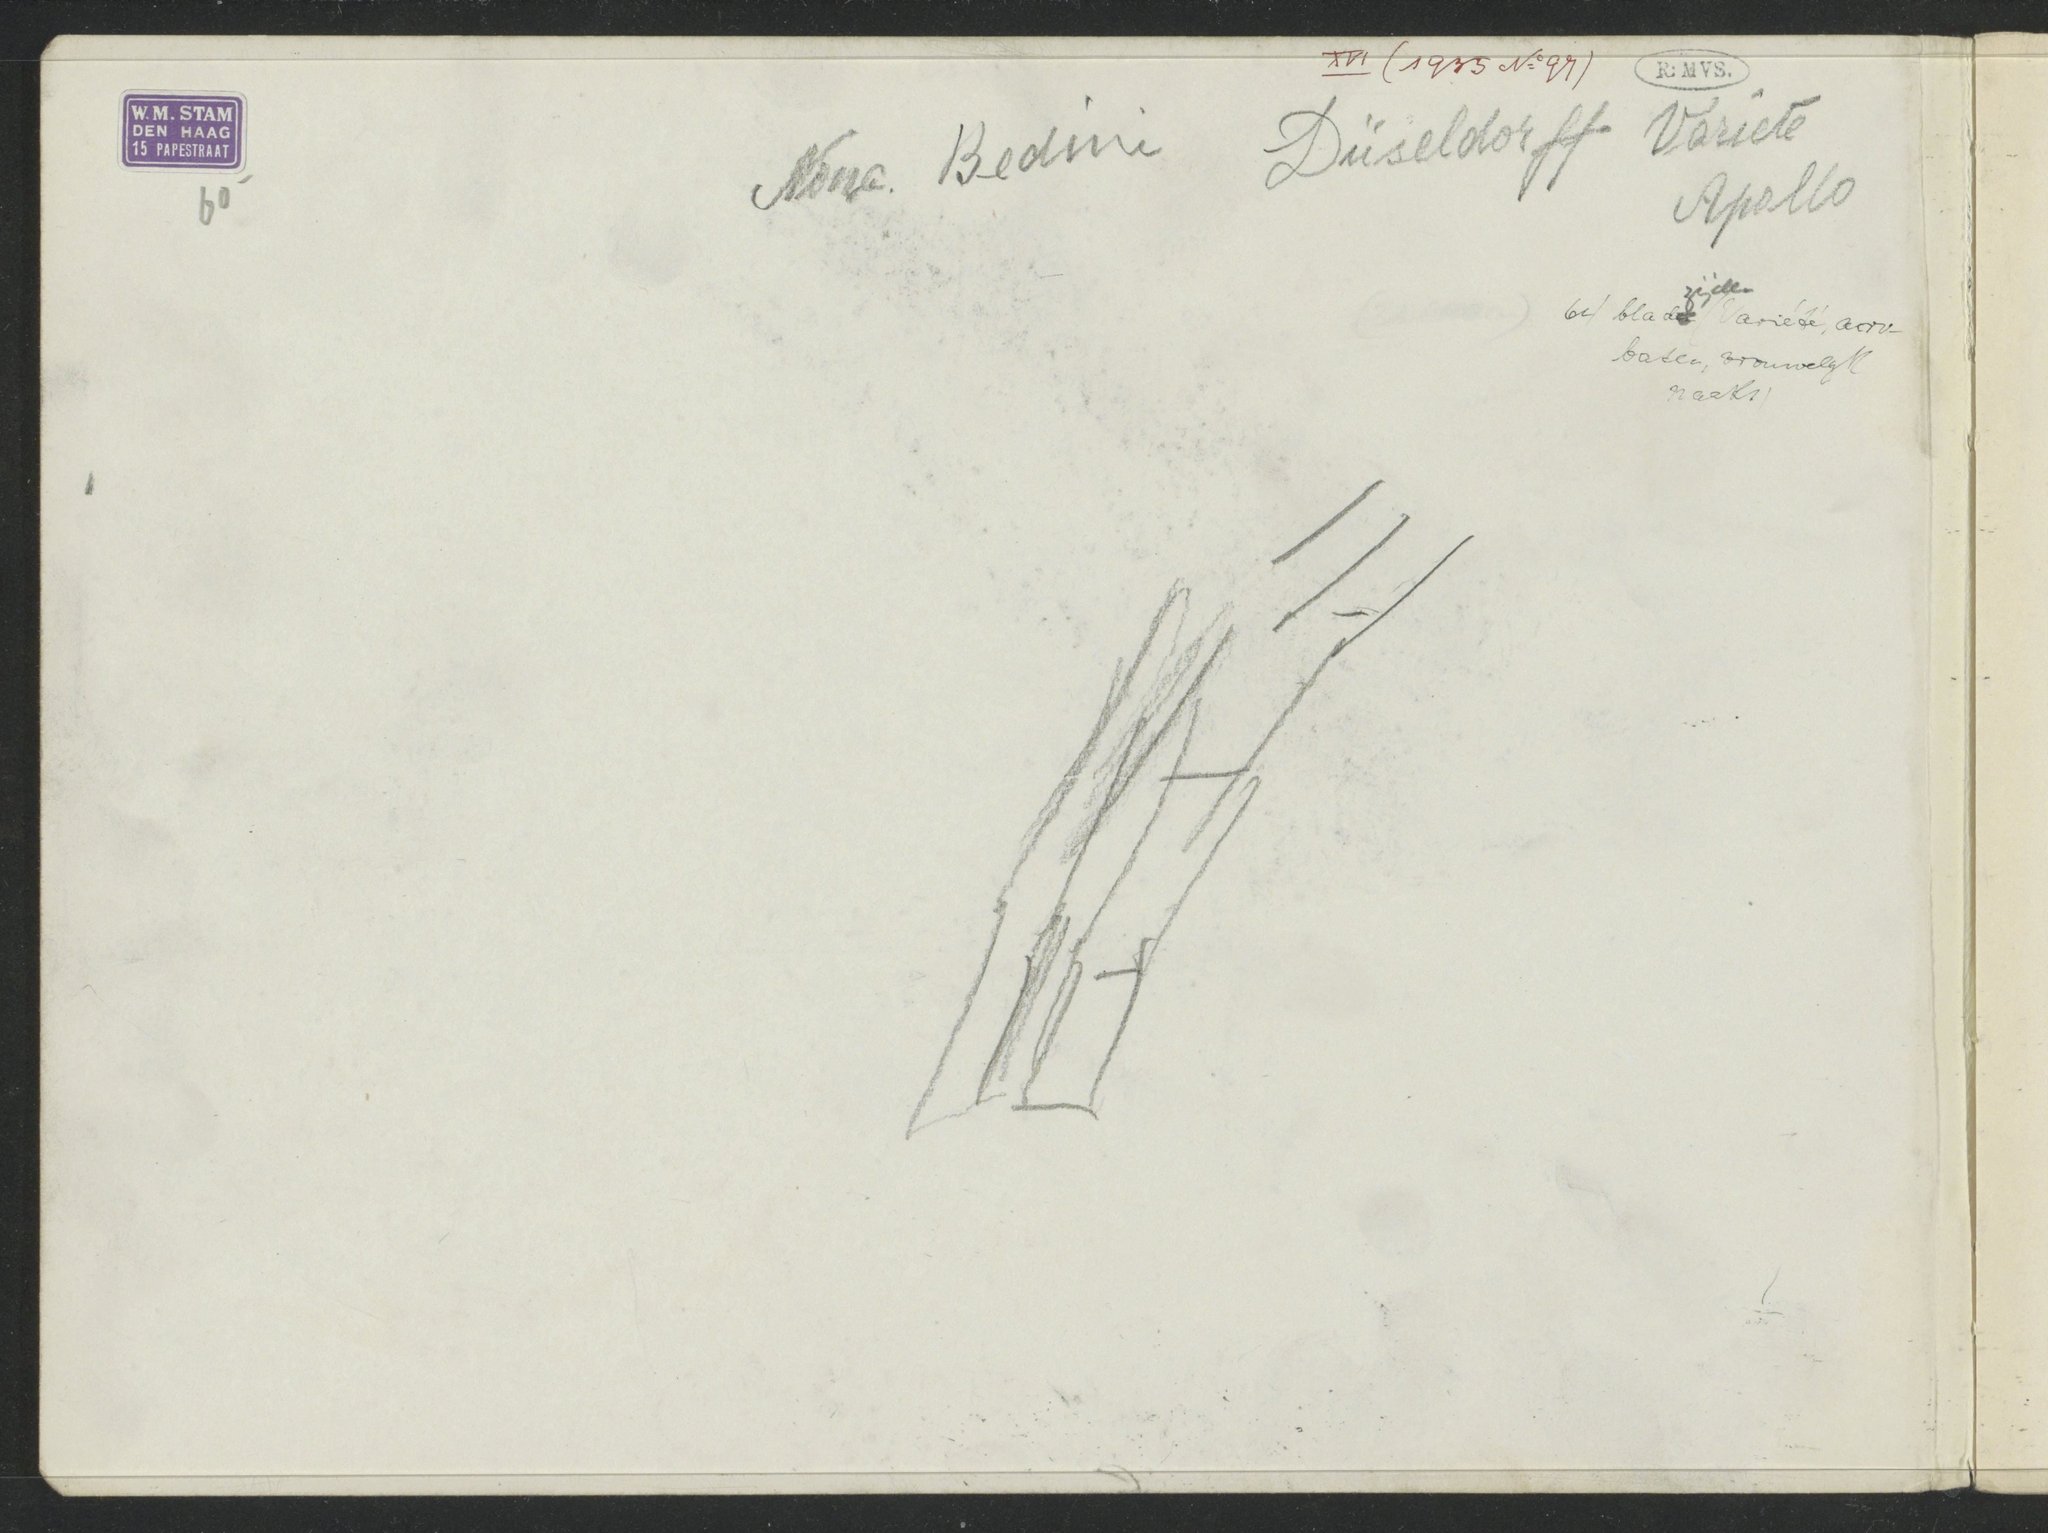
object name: endleaf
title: Architectuurstudie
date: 1915-1934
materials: paper, pencil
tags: architectural detail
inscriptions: label: ‘W.M. Stam / Den Haag / 15 Papestraat’, annotation: ‘[...] Bedini Düsseldorff Variete [sic] / Apollo’, collector's mark: Lugt 2228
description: Schutblad A, voorste schutblad, uit schetsboek XVI met 32 bladen.